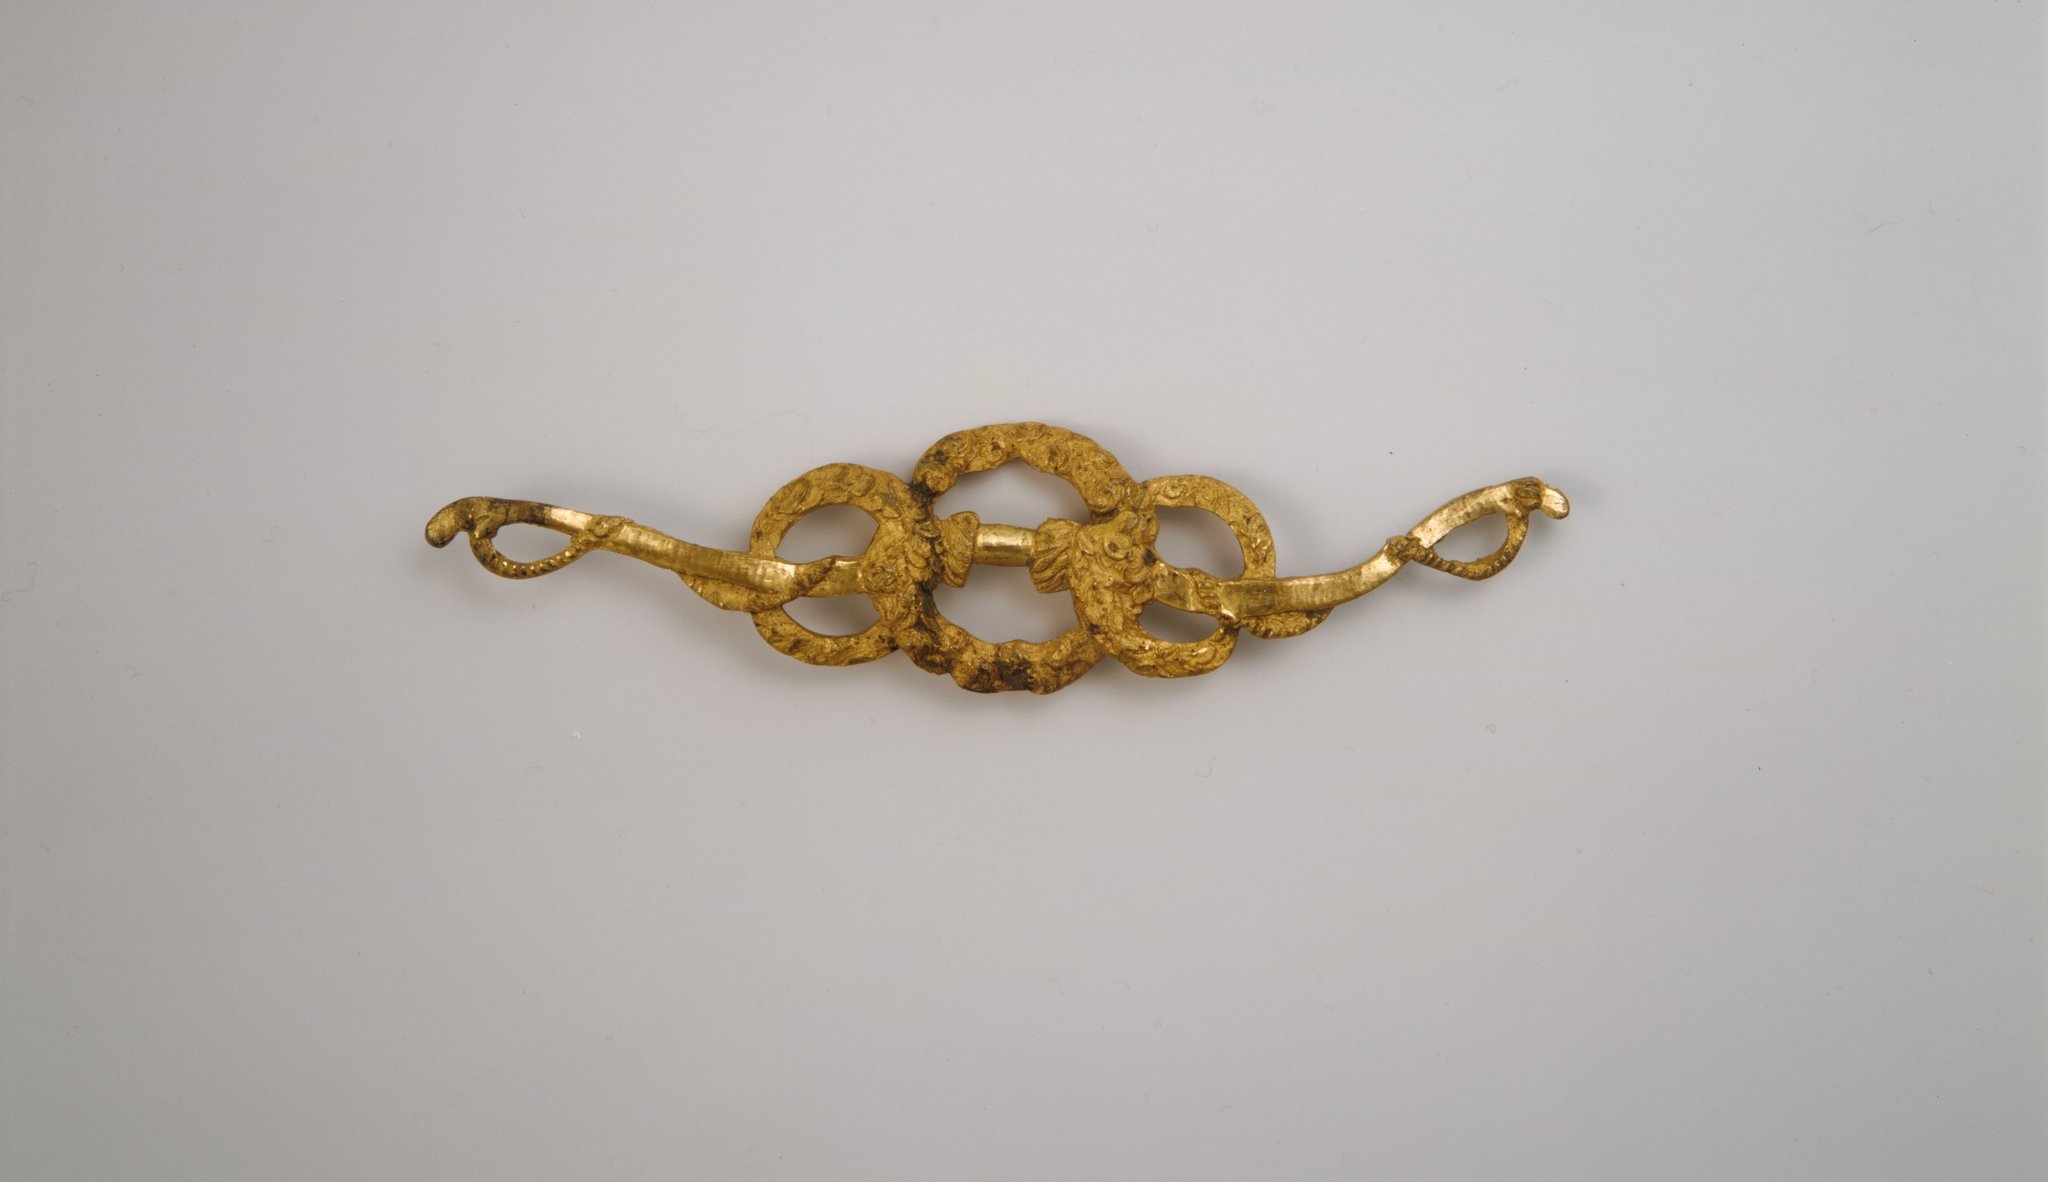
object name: furniture hardware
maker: henry kellam hancock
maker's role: retailer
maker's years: 1816-1851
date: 1820-1830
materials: brass, gilt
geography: france